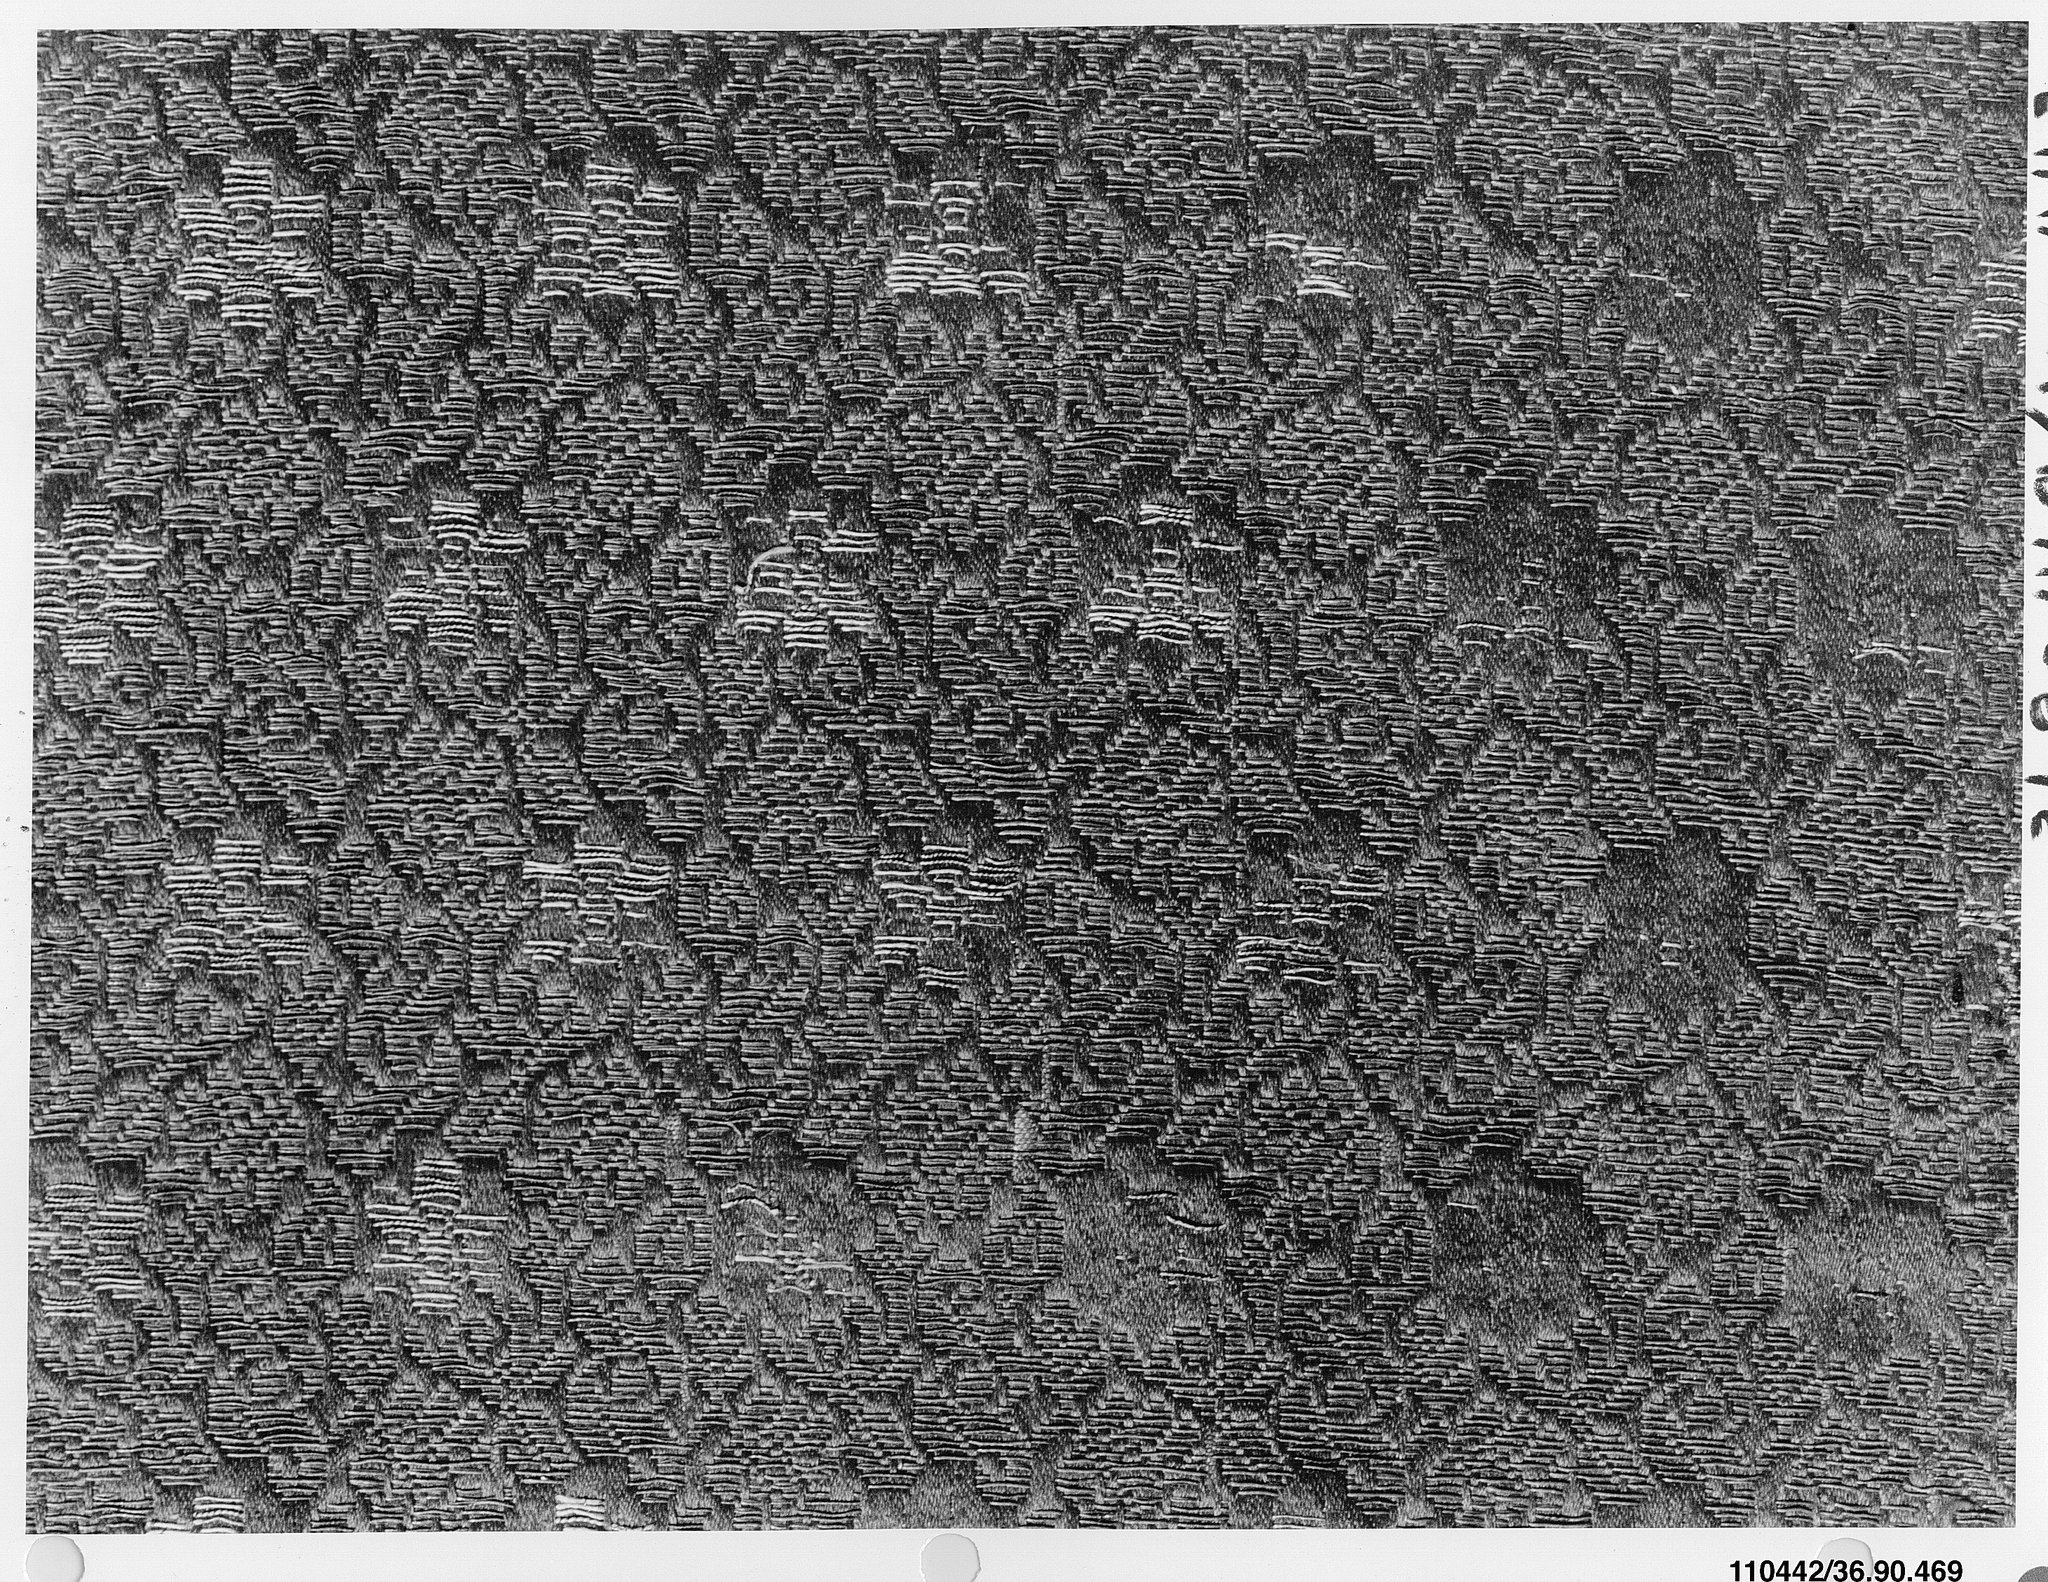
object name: piece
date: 1501-1700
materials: metal thread, silk